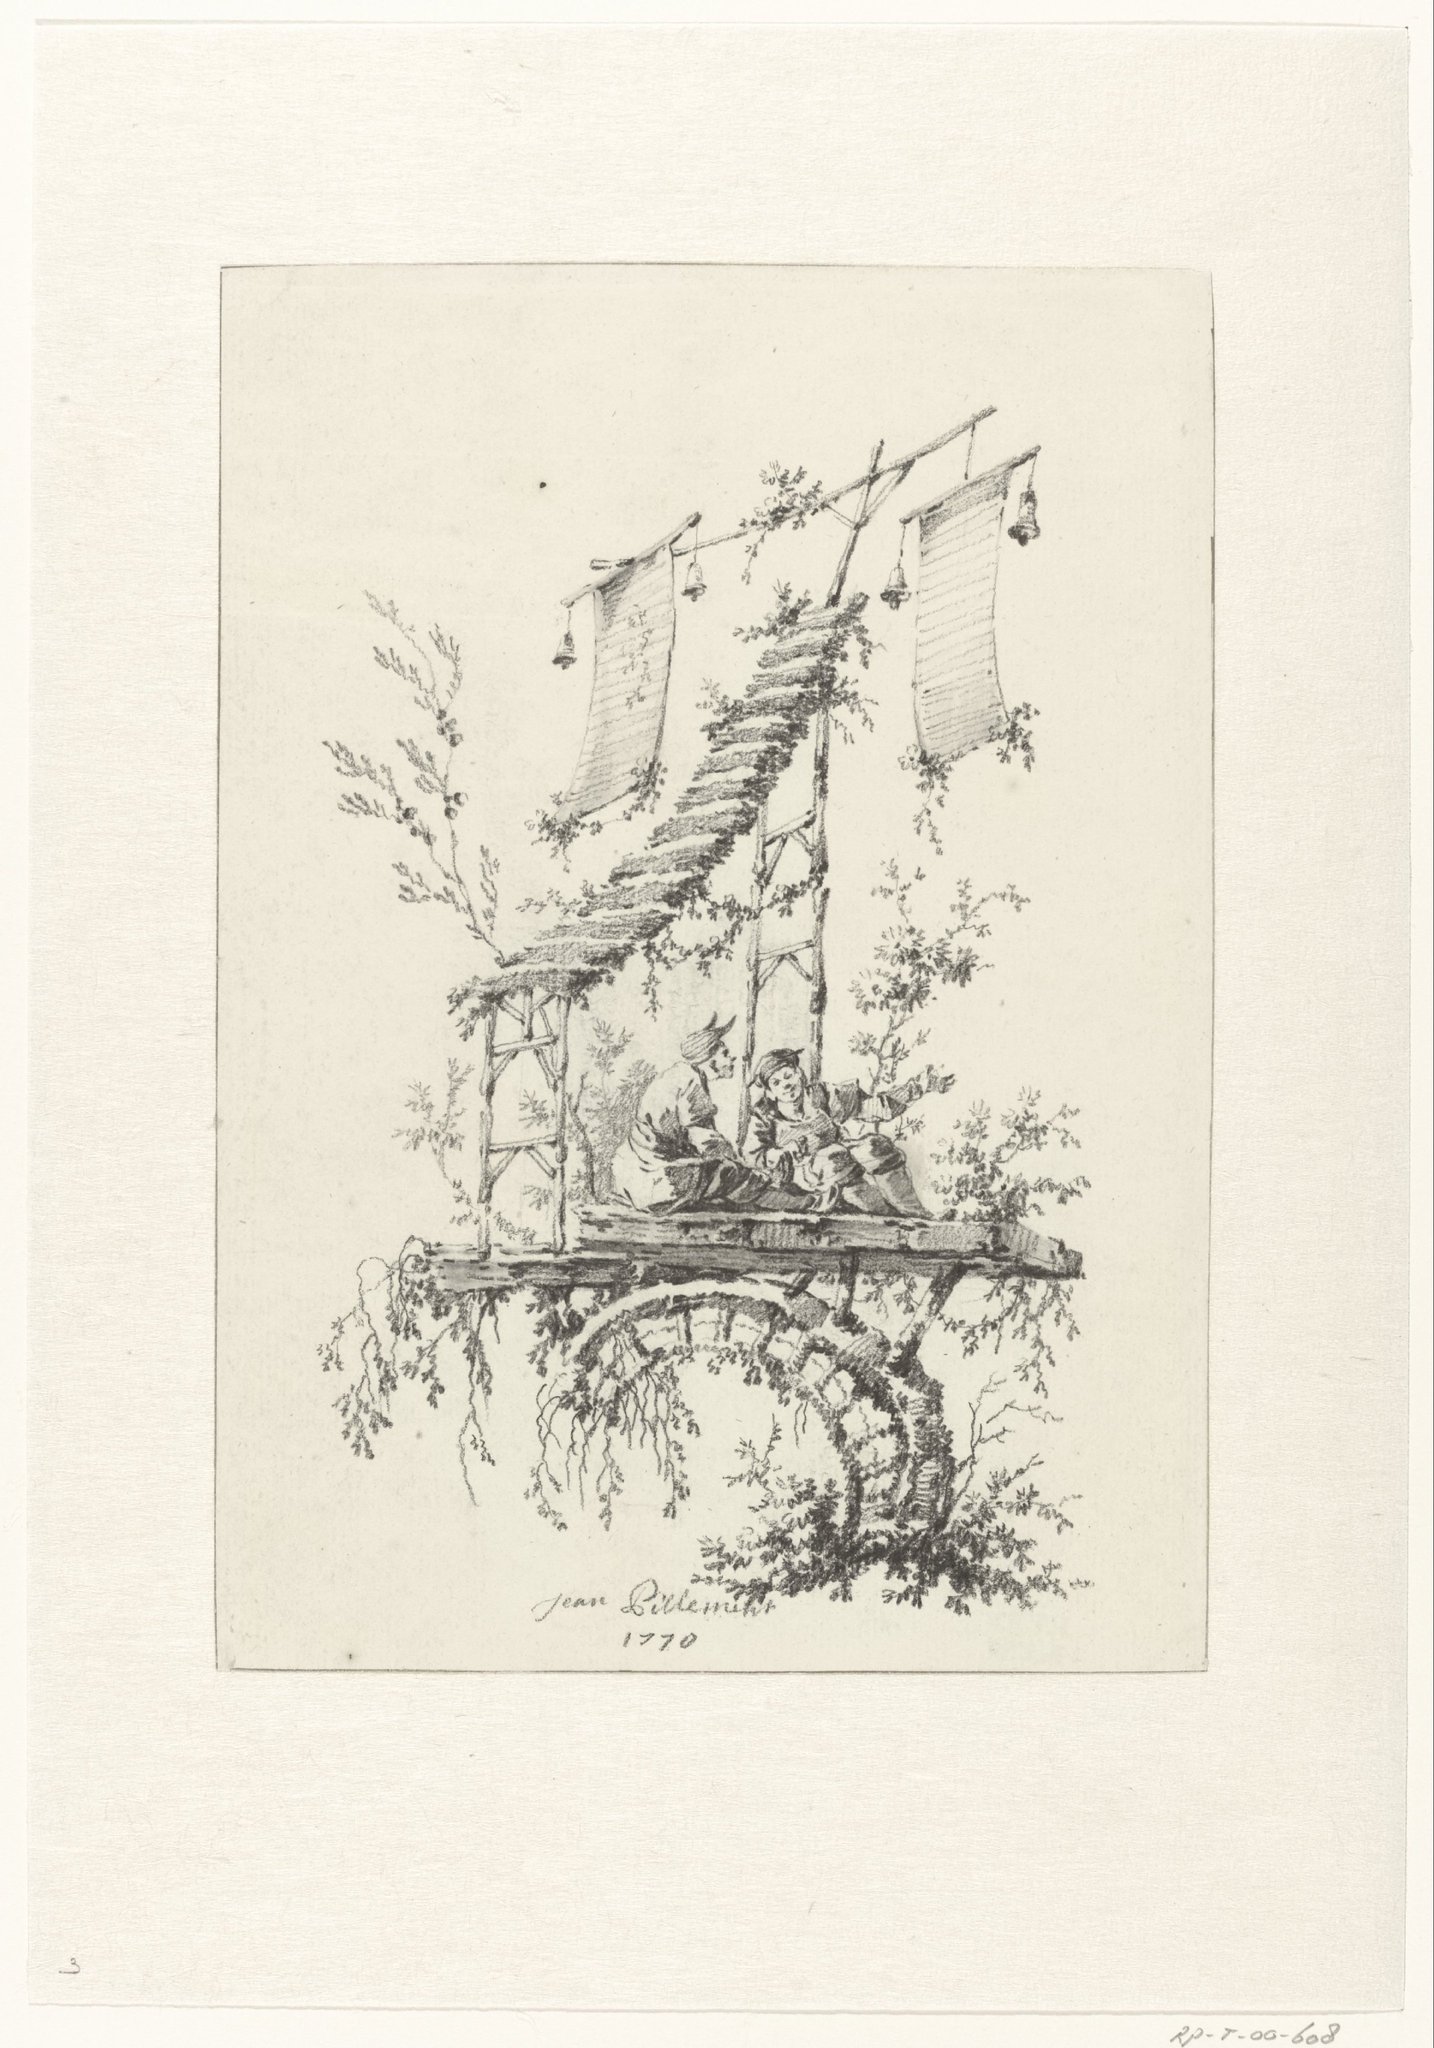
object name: design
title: Ornamentale ontwerpen in chinoiserie-stijl voor Deuxième Cahier de six Baraques Chinoises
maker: jean baptiste pillement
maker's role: designer, draughtsman, print maker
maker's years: 1728-1808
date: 1770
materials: chalk, paper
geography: paris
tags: viola, violoncello; double bass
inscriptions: signature and date, recto, lower centre, black chalk: ‘jean Pillement // 1770’, collector's mark, verso, lower left: Lugt 2165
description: Blad uit serie ornamentale composities in chinoiserie-stijl, ontwerpen voor "Deuxième Cahier de six Baraques Chinoises".